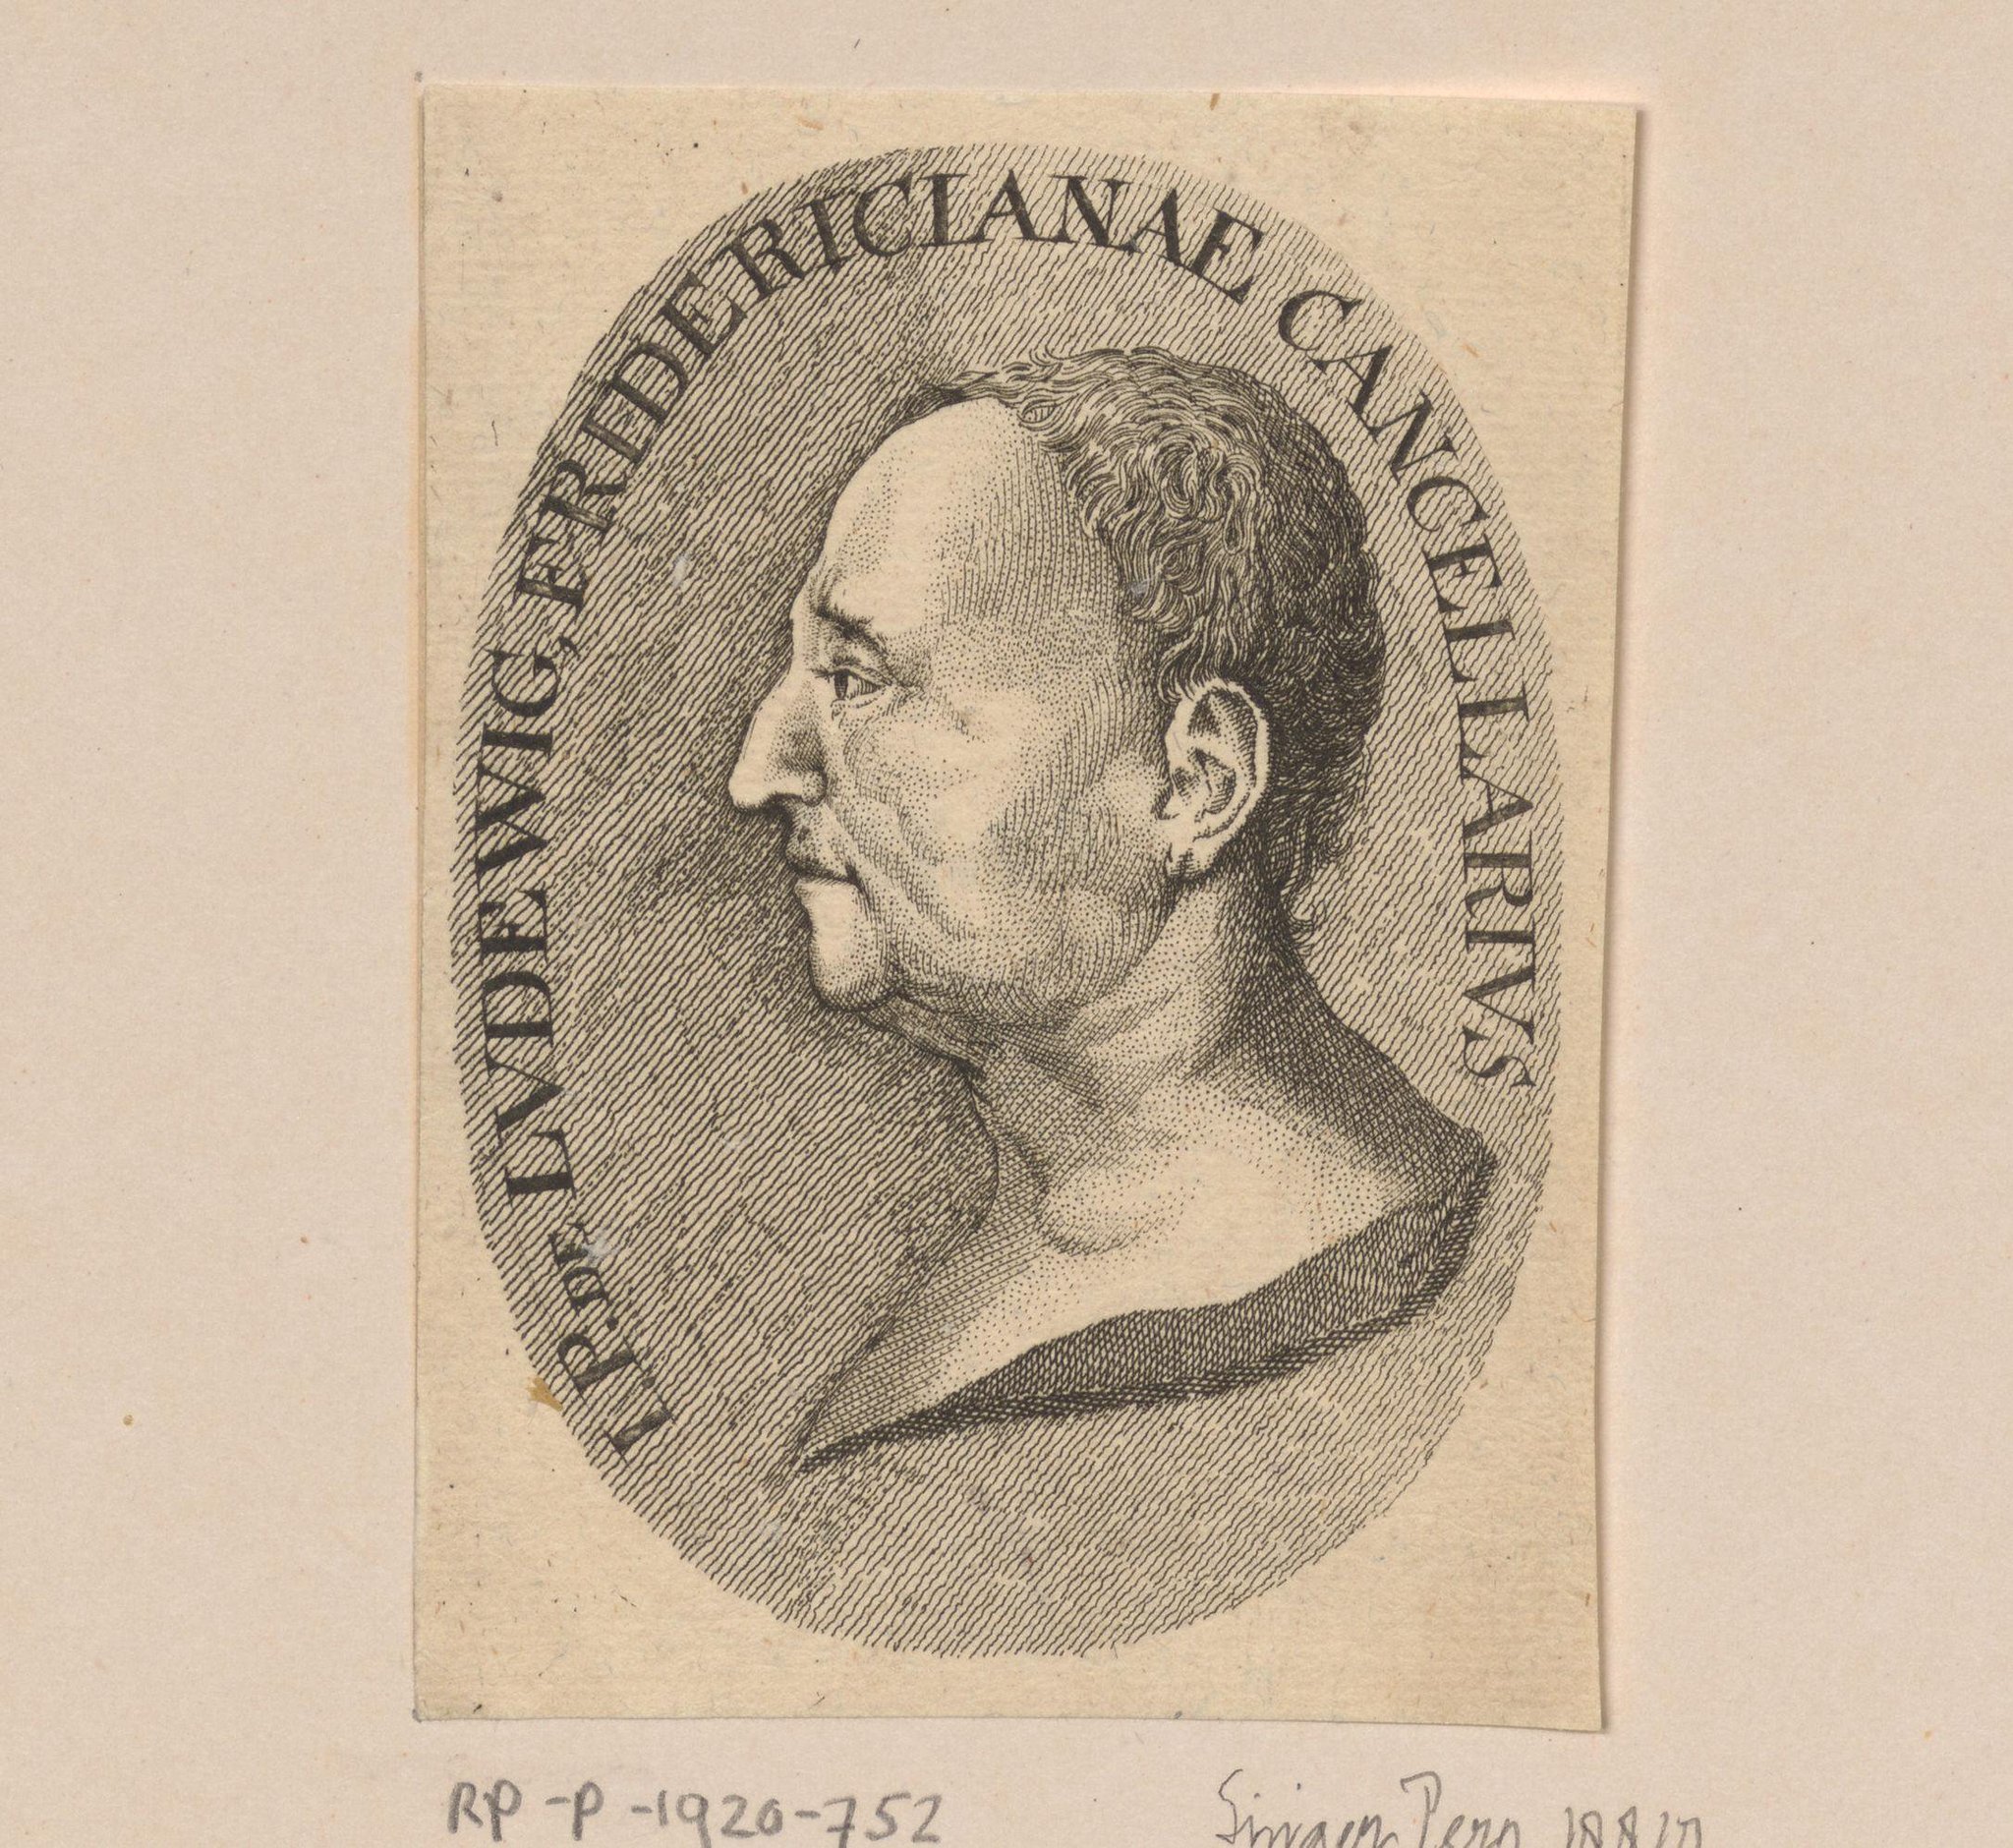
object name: print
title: Portret van Johann Peter von Ludewig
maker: Anonymous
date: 1720-1799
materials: paper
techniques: etching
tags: history and archaeology (+ portrait of scholar, scientist), historical persons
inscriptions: collector's mark: Lugt 2228